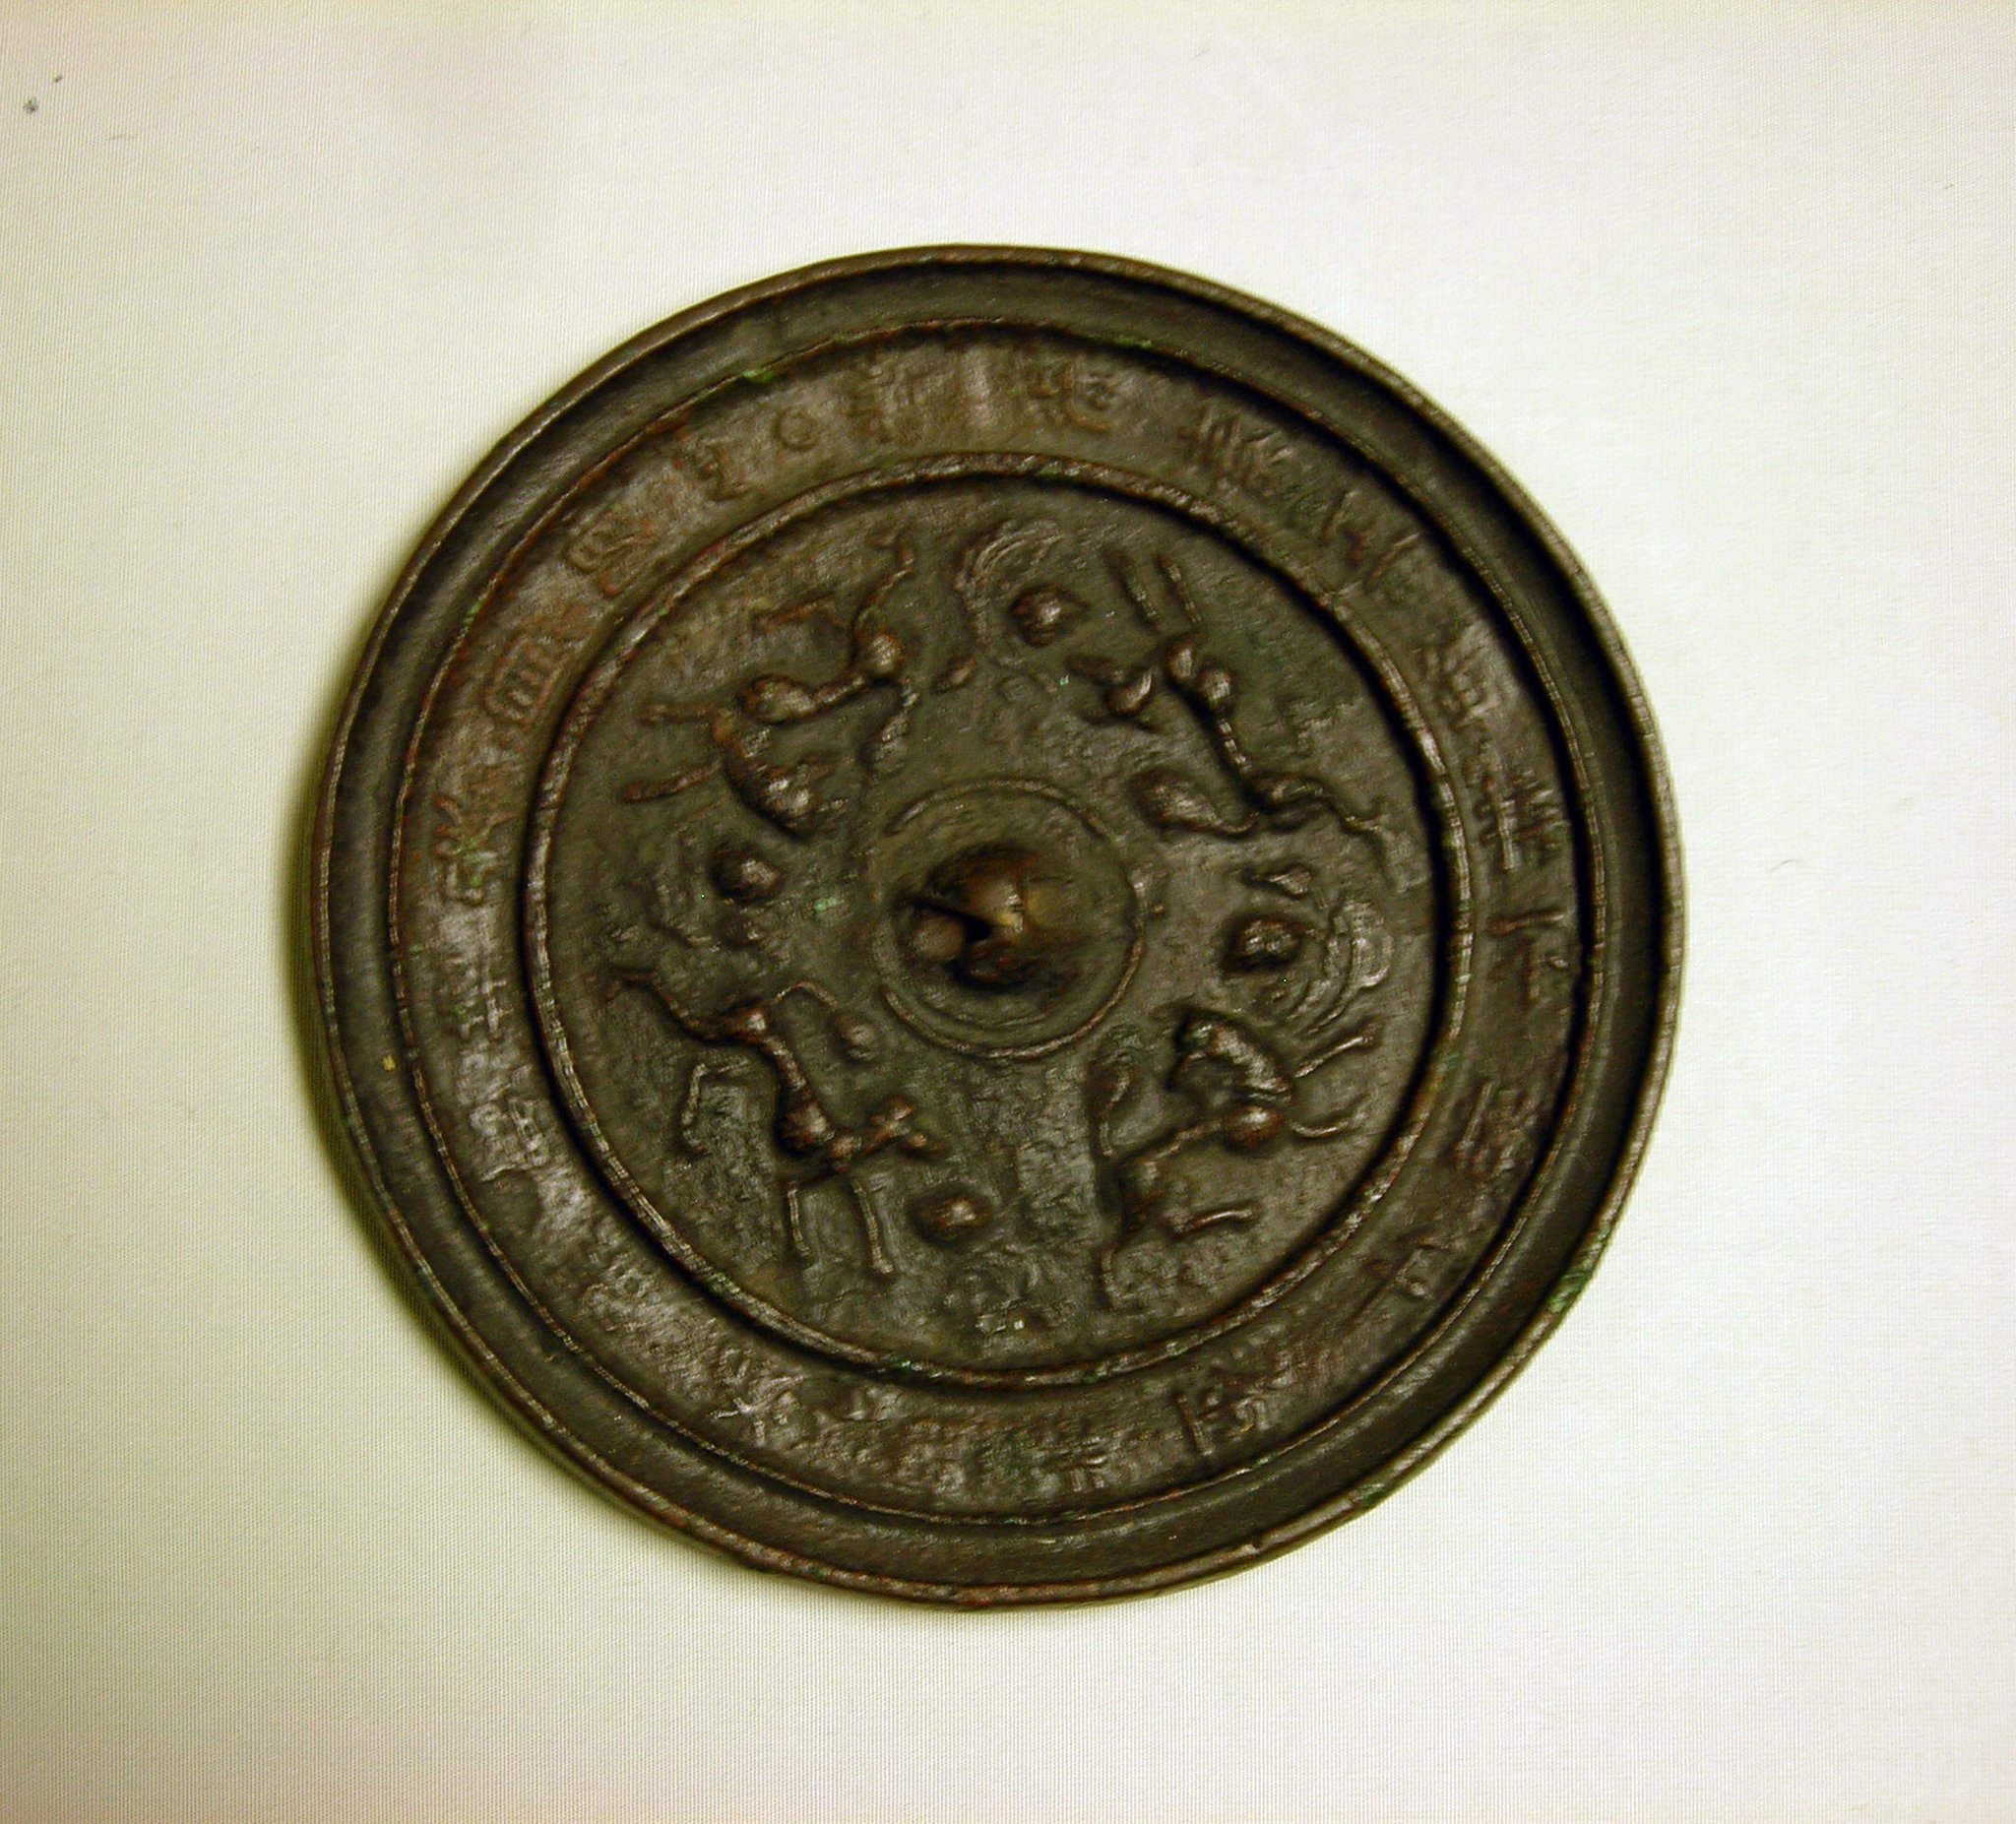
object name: mirror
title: Mirror in Han style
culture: chinese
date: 1301-1500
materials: bronze